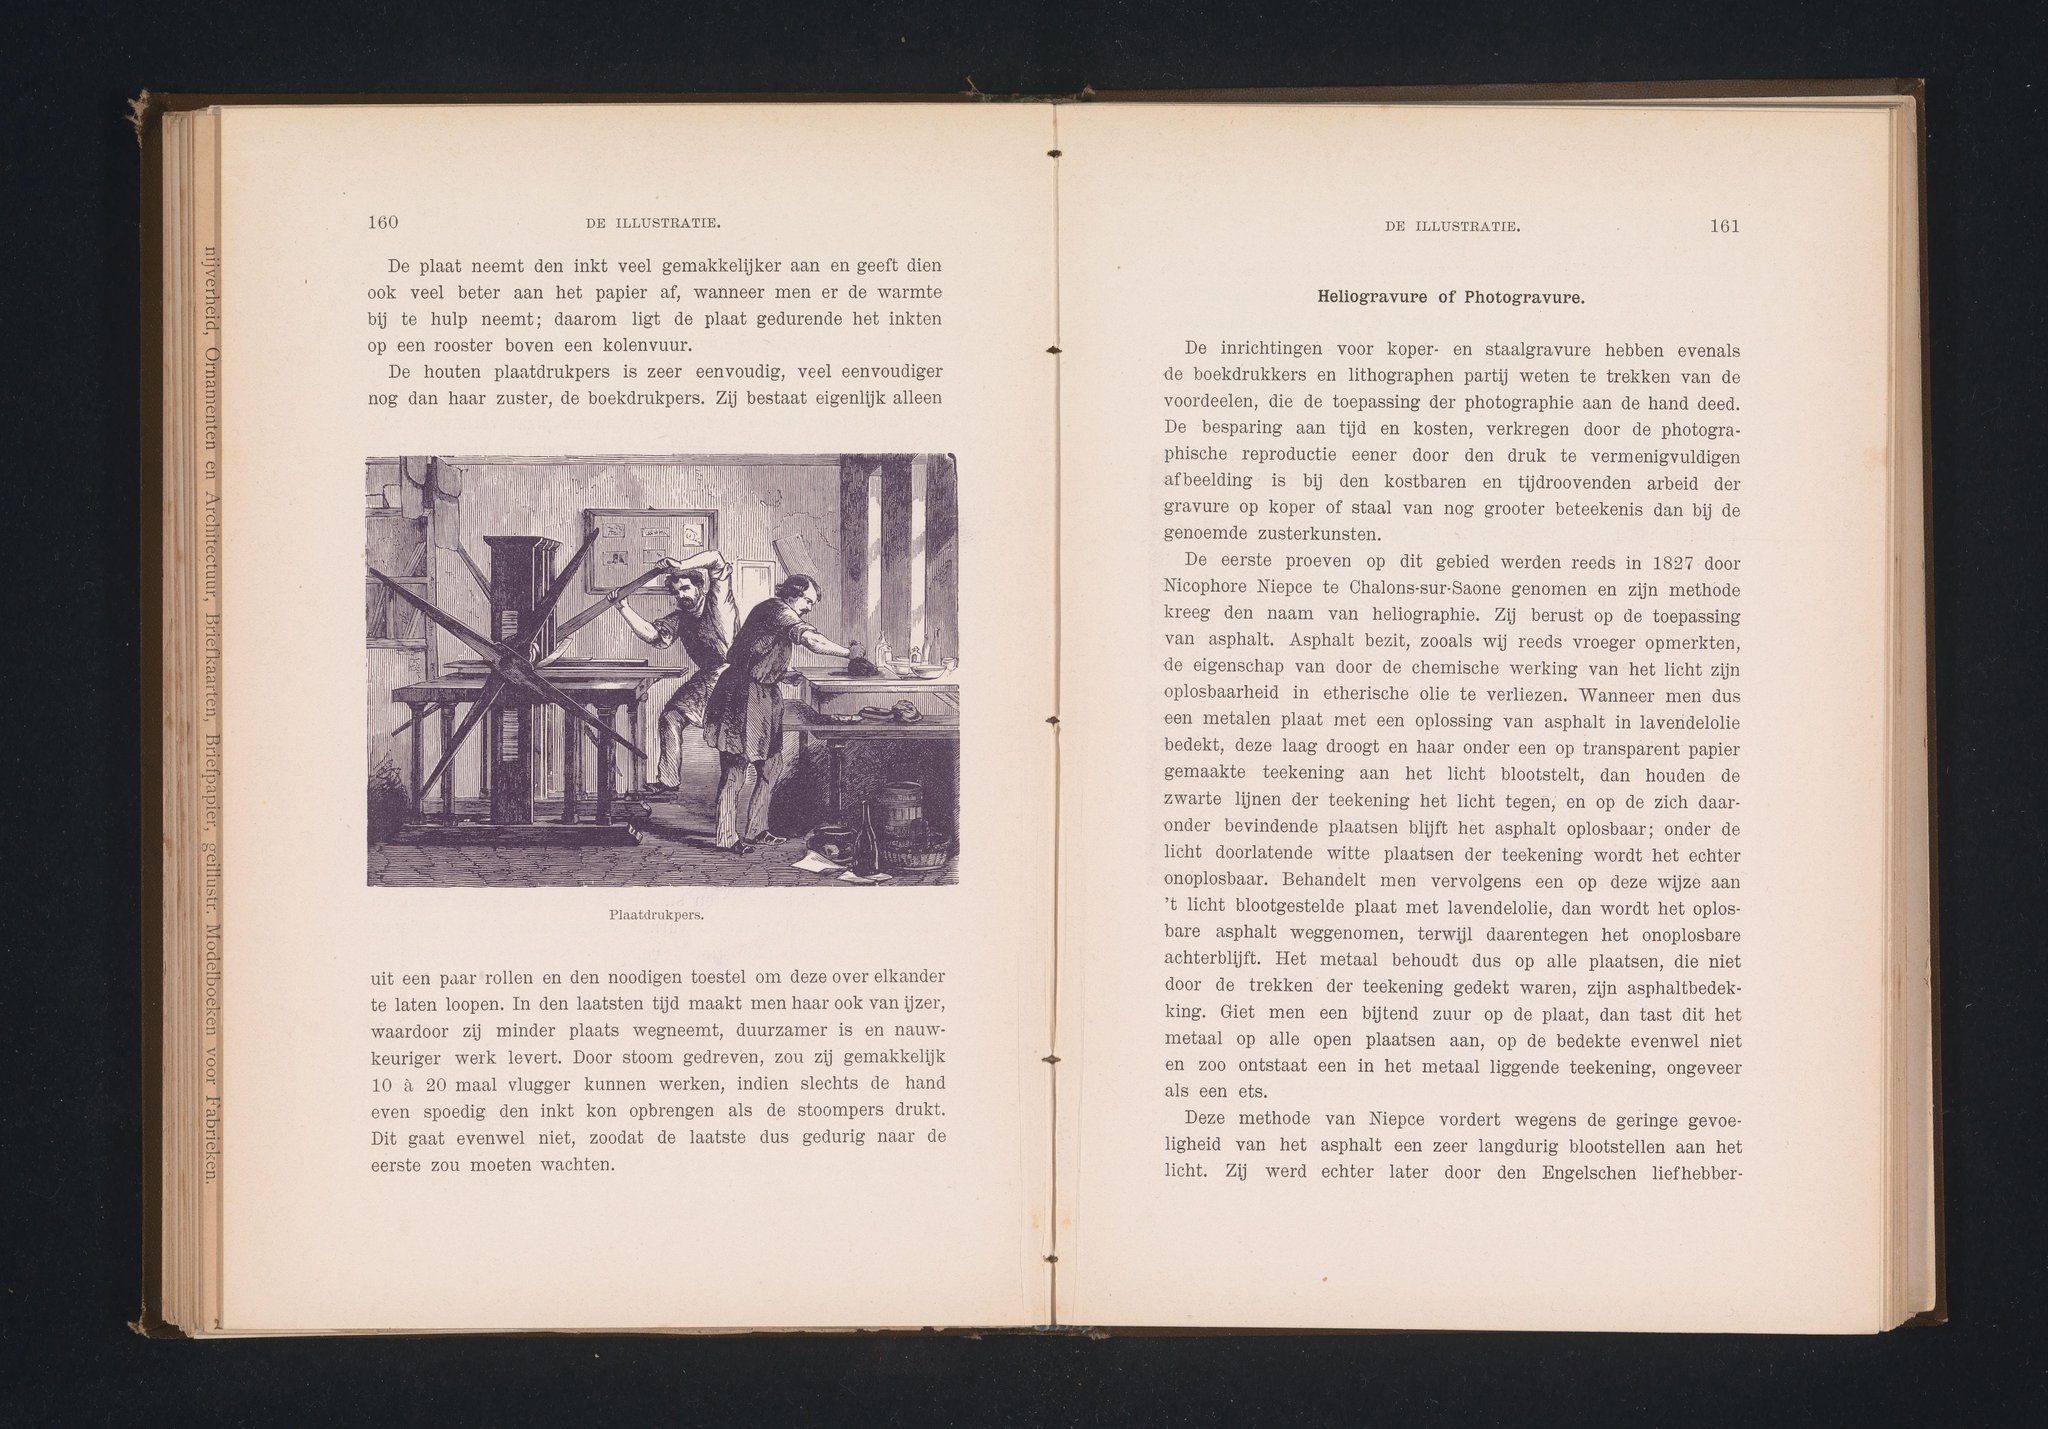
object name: photomechanical print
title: Plaatdrukpers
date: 1887-1892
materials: paper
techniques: printing block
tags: adult man, printing press